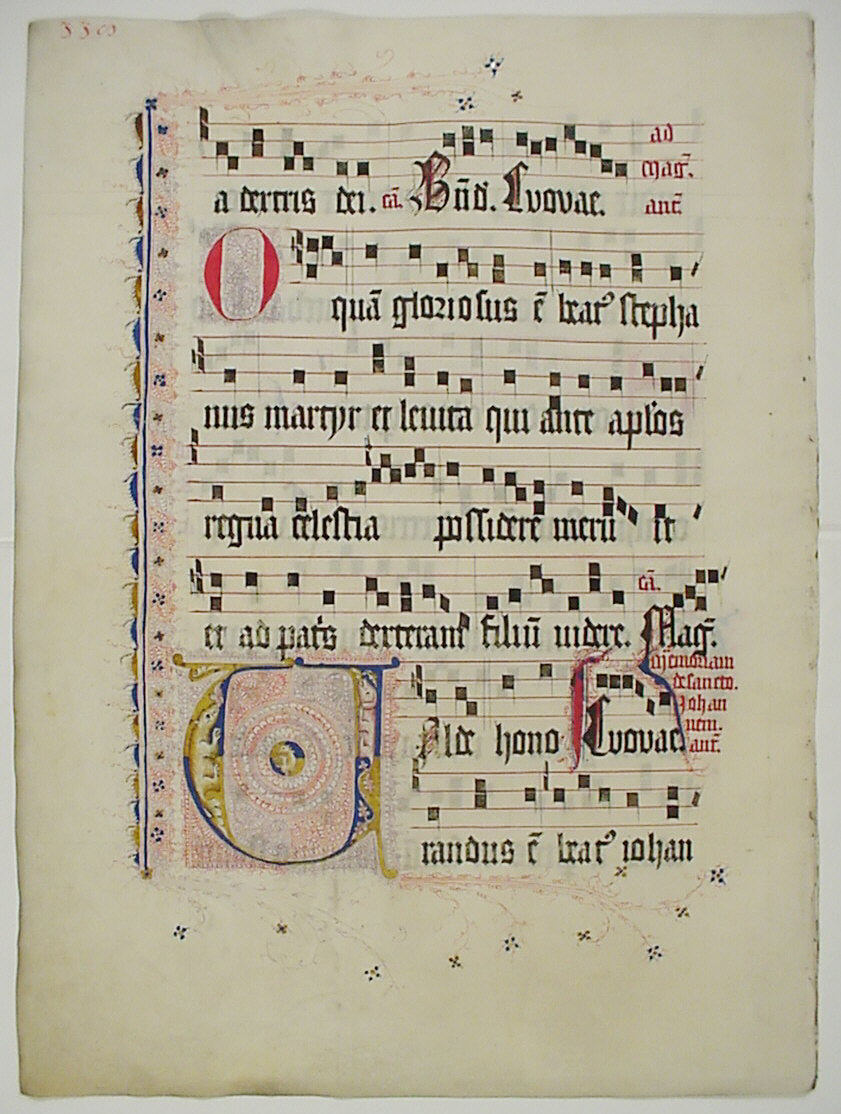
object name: antiphonary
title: Manuscript Leaf with Initial V, from an Antiphonary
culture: german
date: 1426-1450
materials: ink, metal leaf, parchment, paint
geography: germany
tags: birds,music